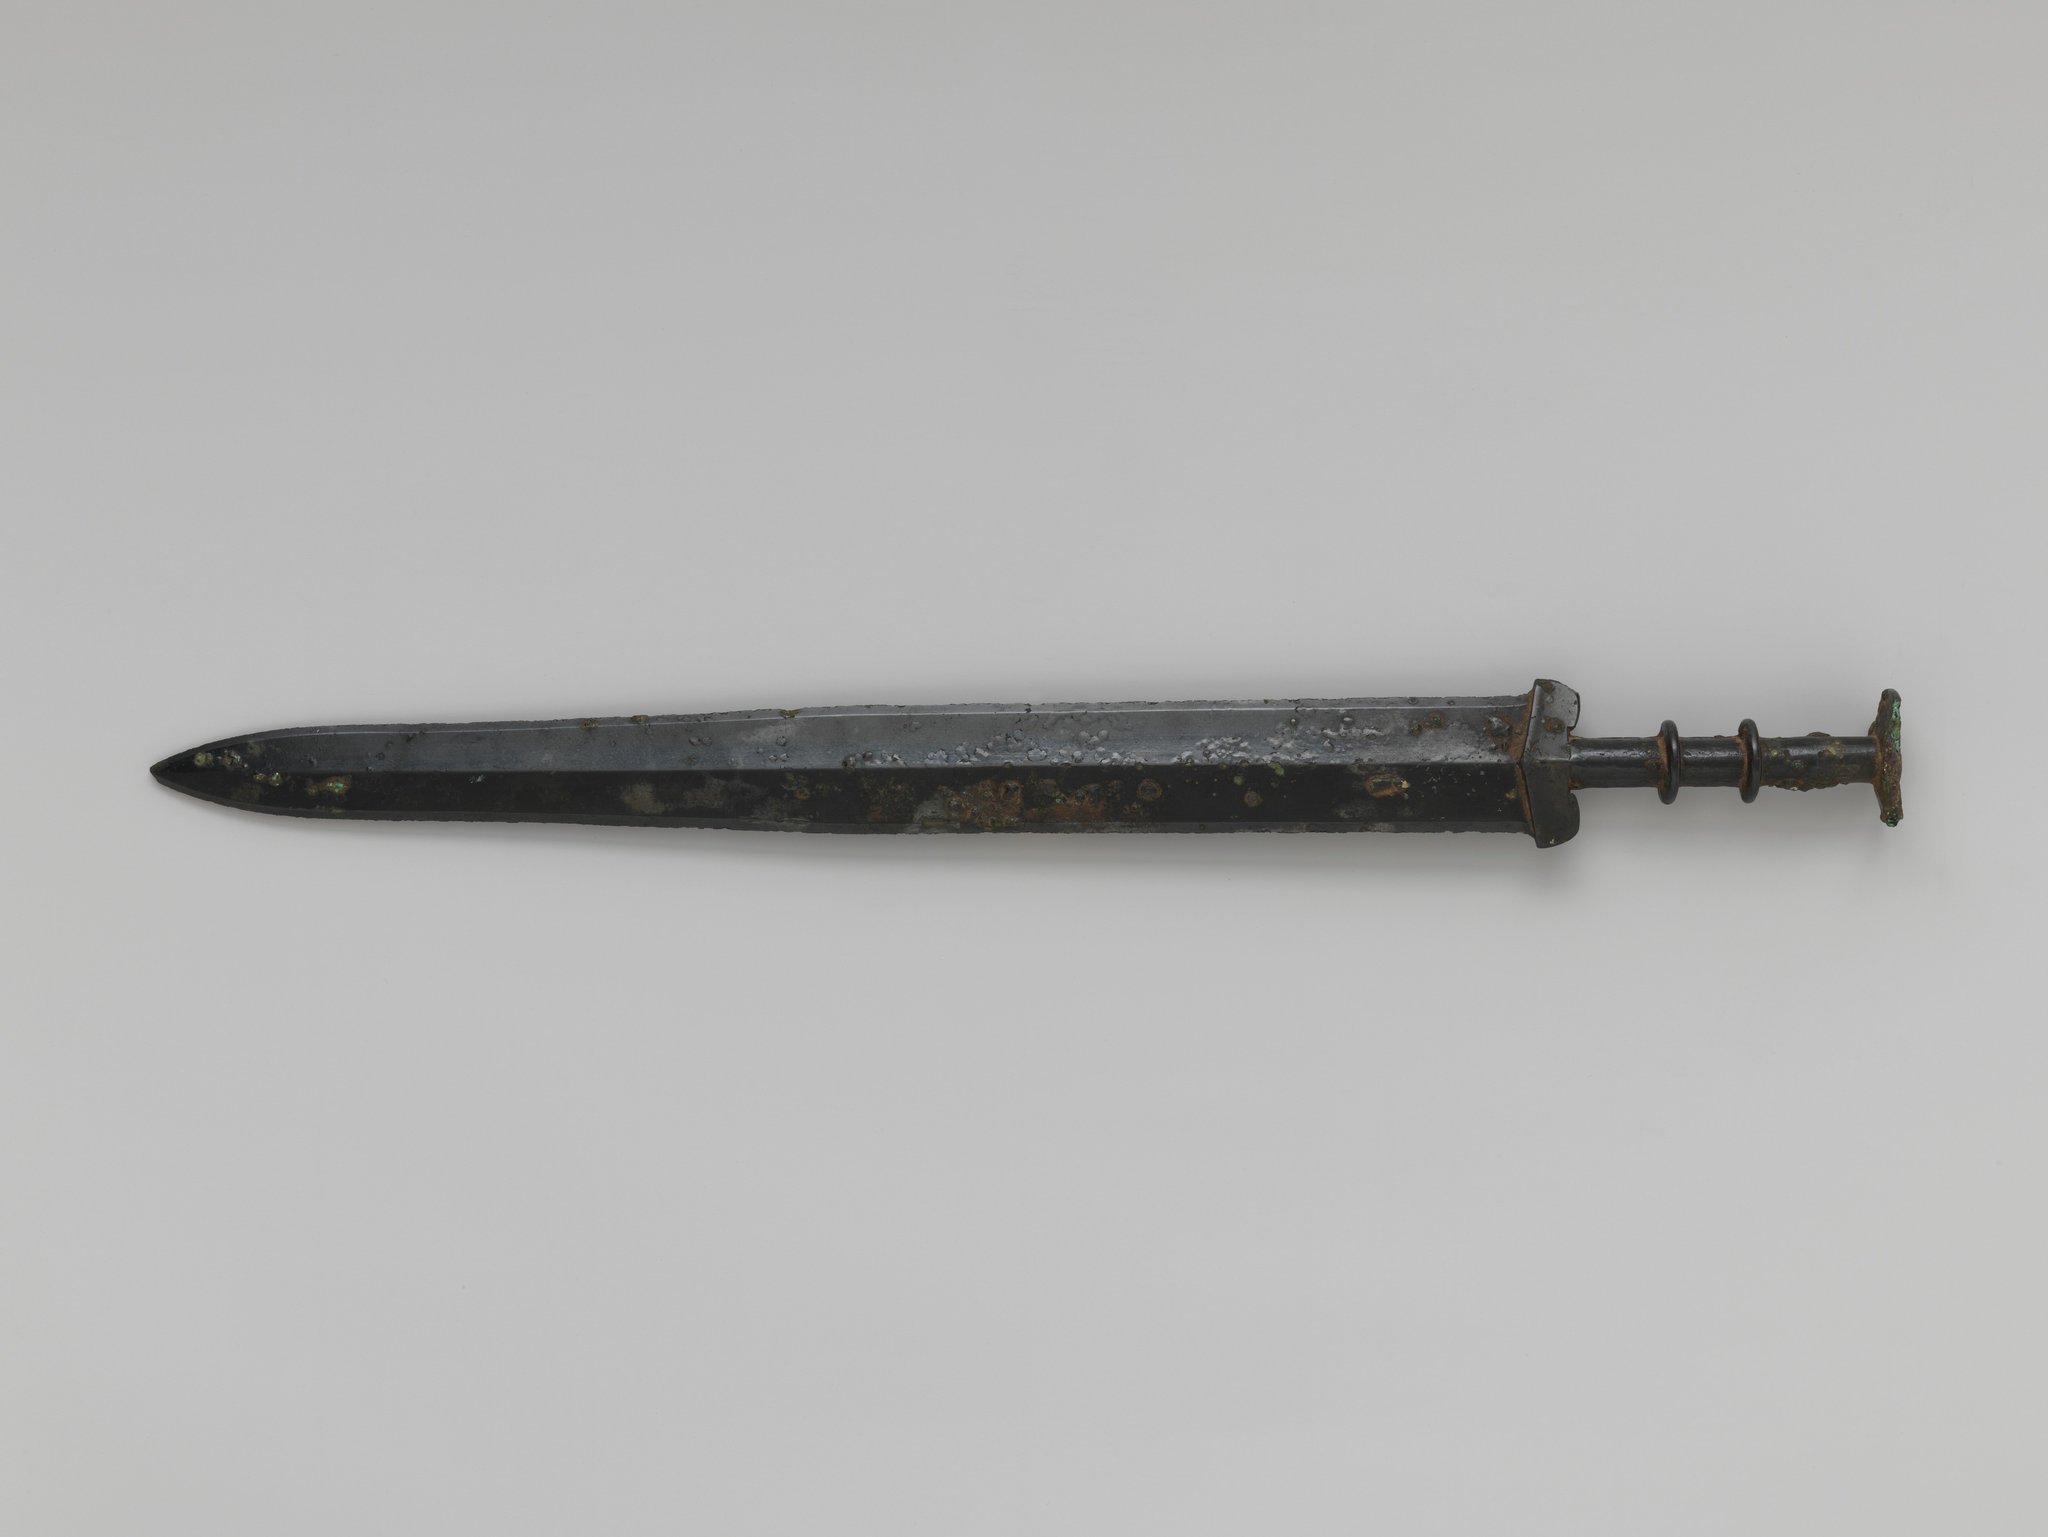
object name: sword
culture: chinese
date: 1046-256 BCE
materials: bronze, lacquer, patina